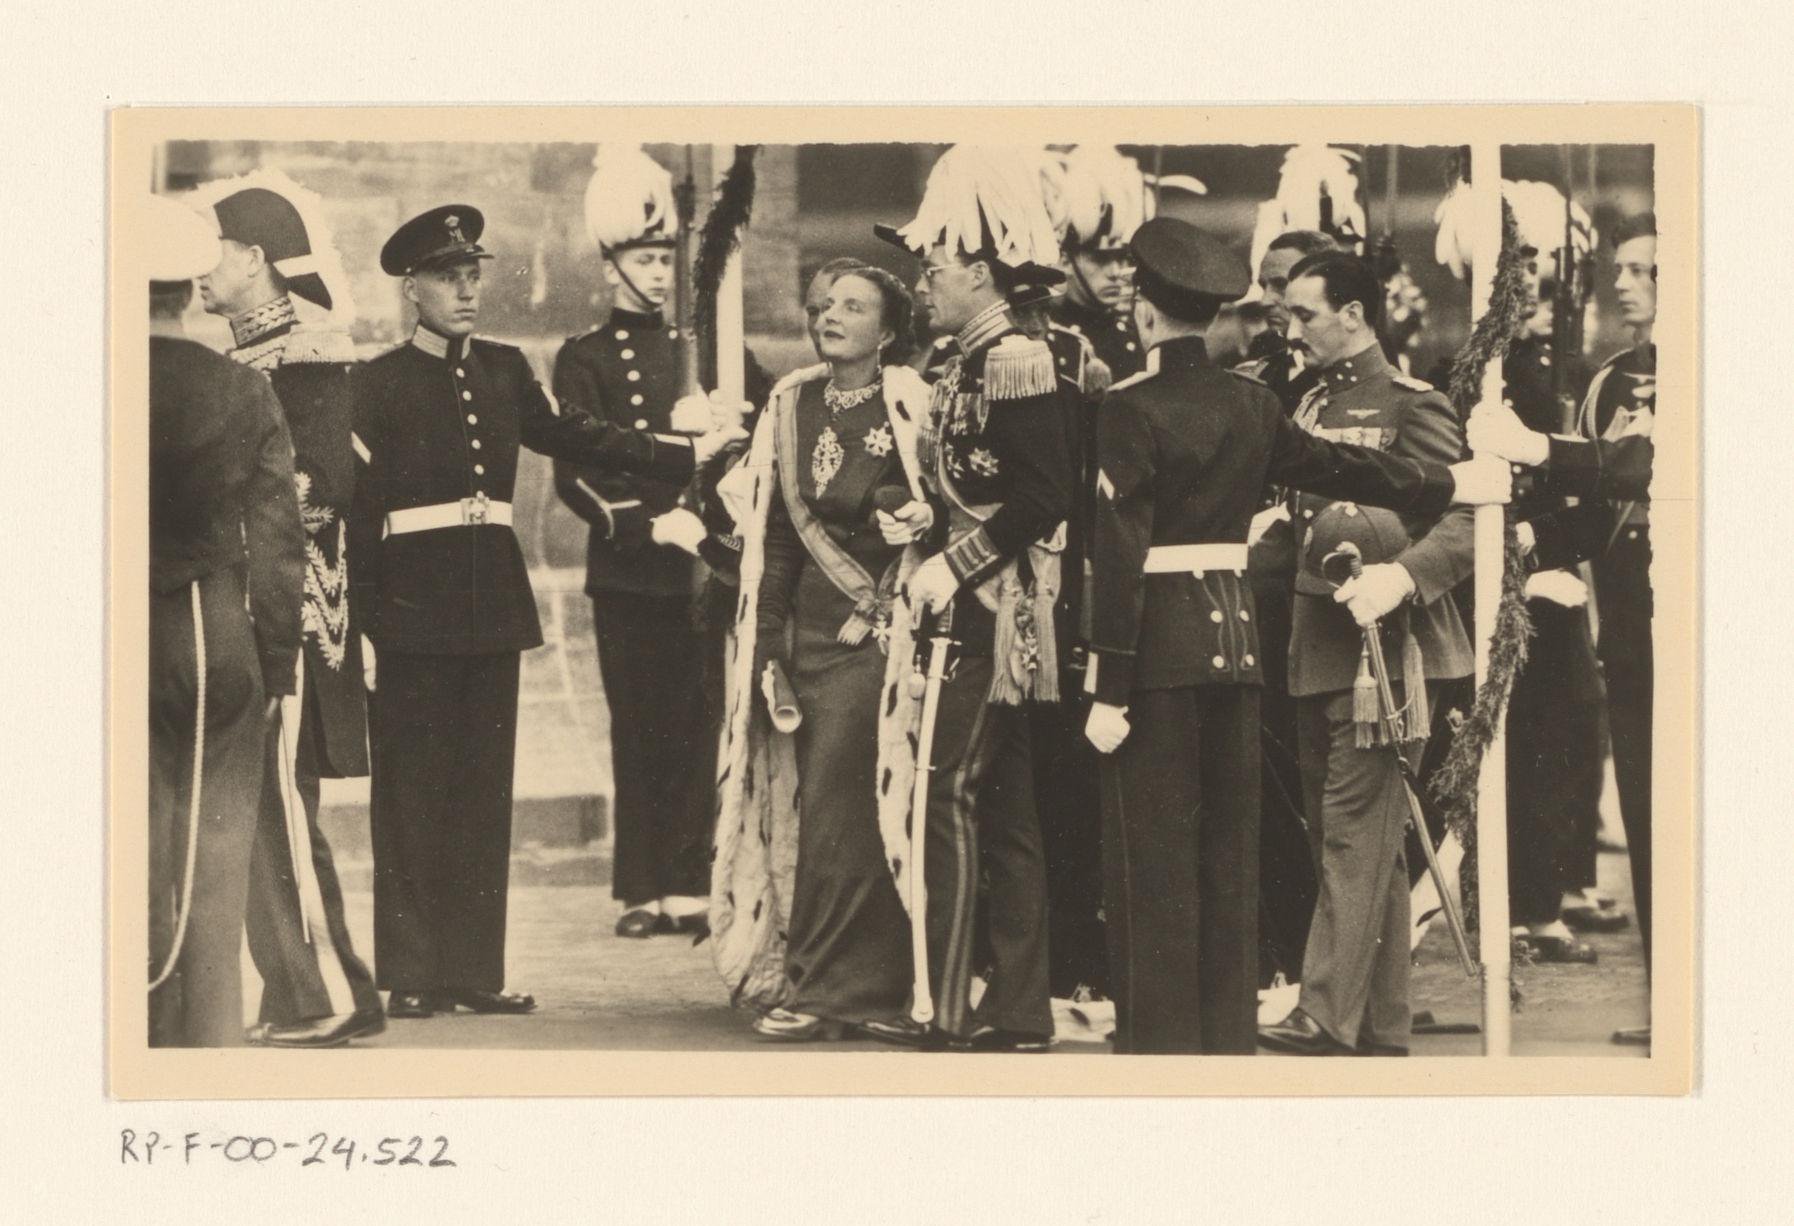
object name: photograph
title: H.M. Koningin Juliana verlaat de Nieuwe Kerk na de eedsaflegging / A'dam, 6 Sept. 1948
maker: Anonymous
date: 1948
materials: paper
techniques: gelatin silver print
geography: utrecht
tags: utrecht, bernhard (prins der nederlanden), the hague, juliana of the netherlands, installation of a ruler - bb - female ruler, historical persons - bb - woman, historical persons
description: Koningin Juliana en prins Bernhard verlaten na de inhuldiging de Nieuwe Kerk te Amsterdam op 6 september 1948.